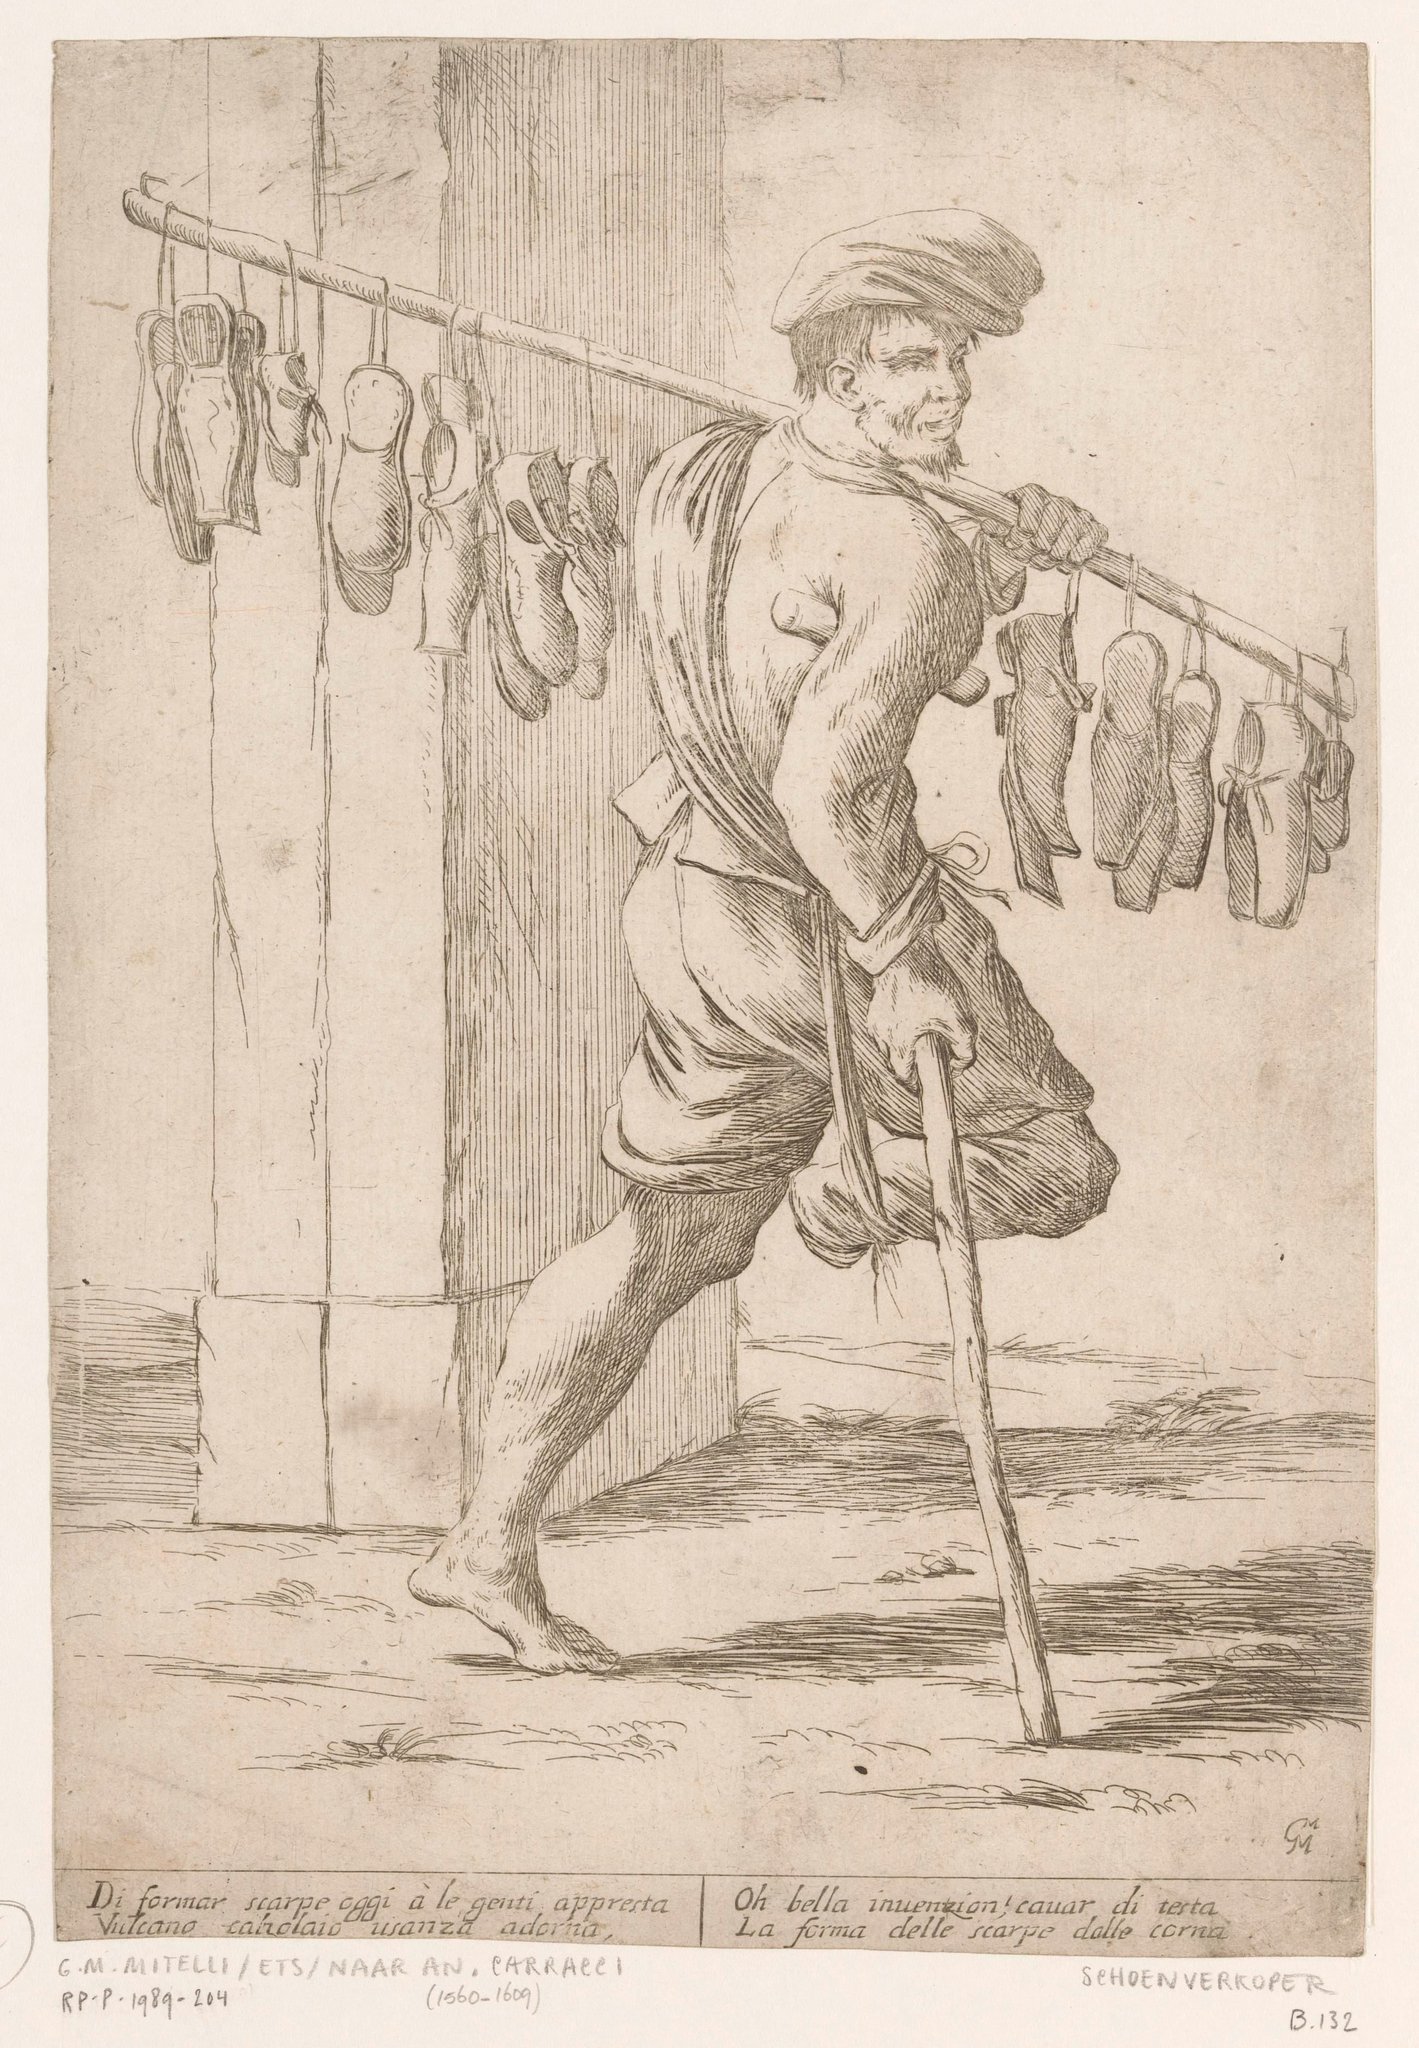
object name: print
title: L'Arti Per Via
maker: giuseppe maria mitelli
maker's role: draughtsman, painter, print maker, publisher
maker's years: 1634-1718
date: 1660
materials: paper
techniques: etching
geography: italy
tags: crutches, person with a physical disability, street-trader, shoes, sandals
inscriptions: collector's mark: Lugt 2228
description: Een man zonder rechteronderbeenbeen, lopend met een okselkruk, balanceert een lange stok waaraan schoenen hangen op zijn linkerschouder. Italiaans vers in ondermarge.